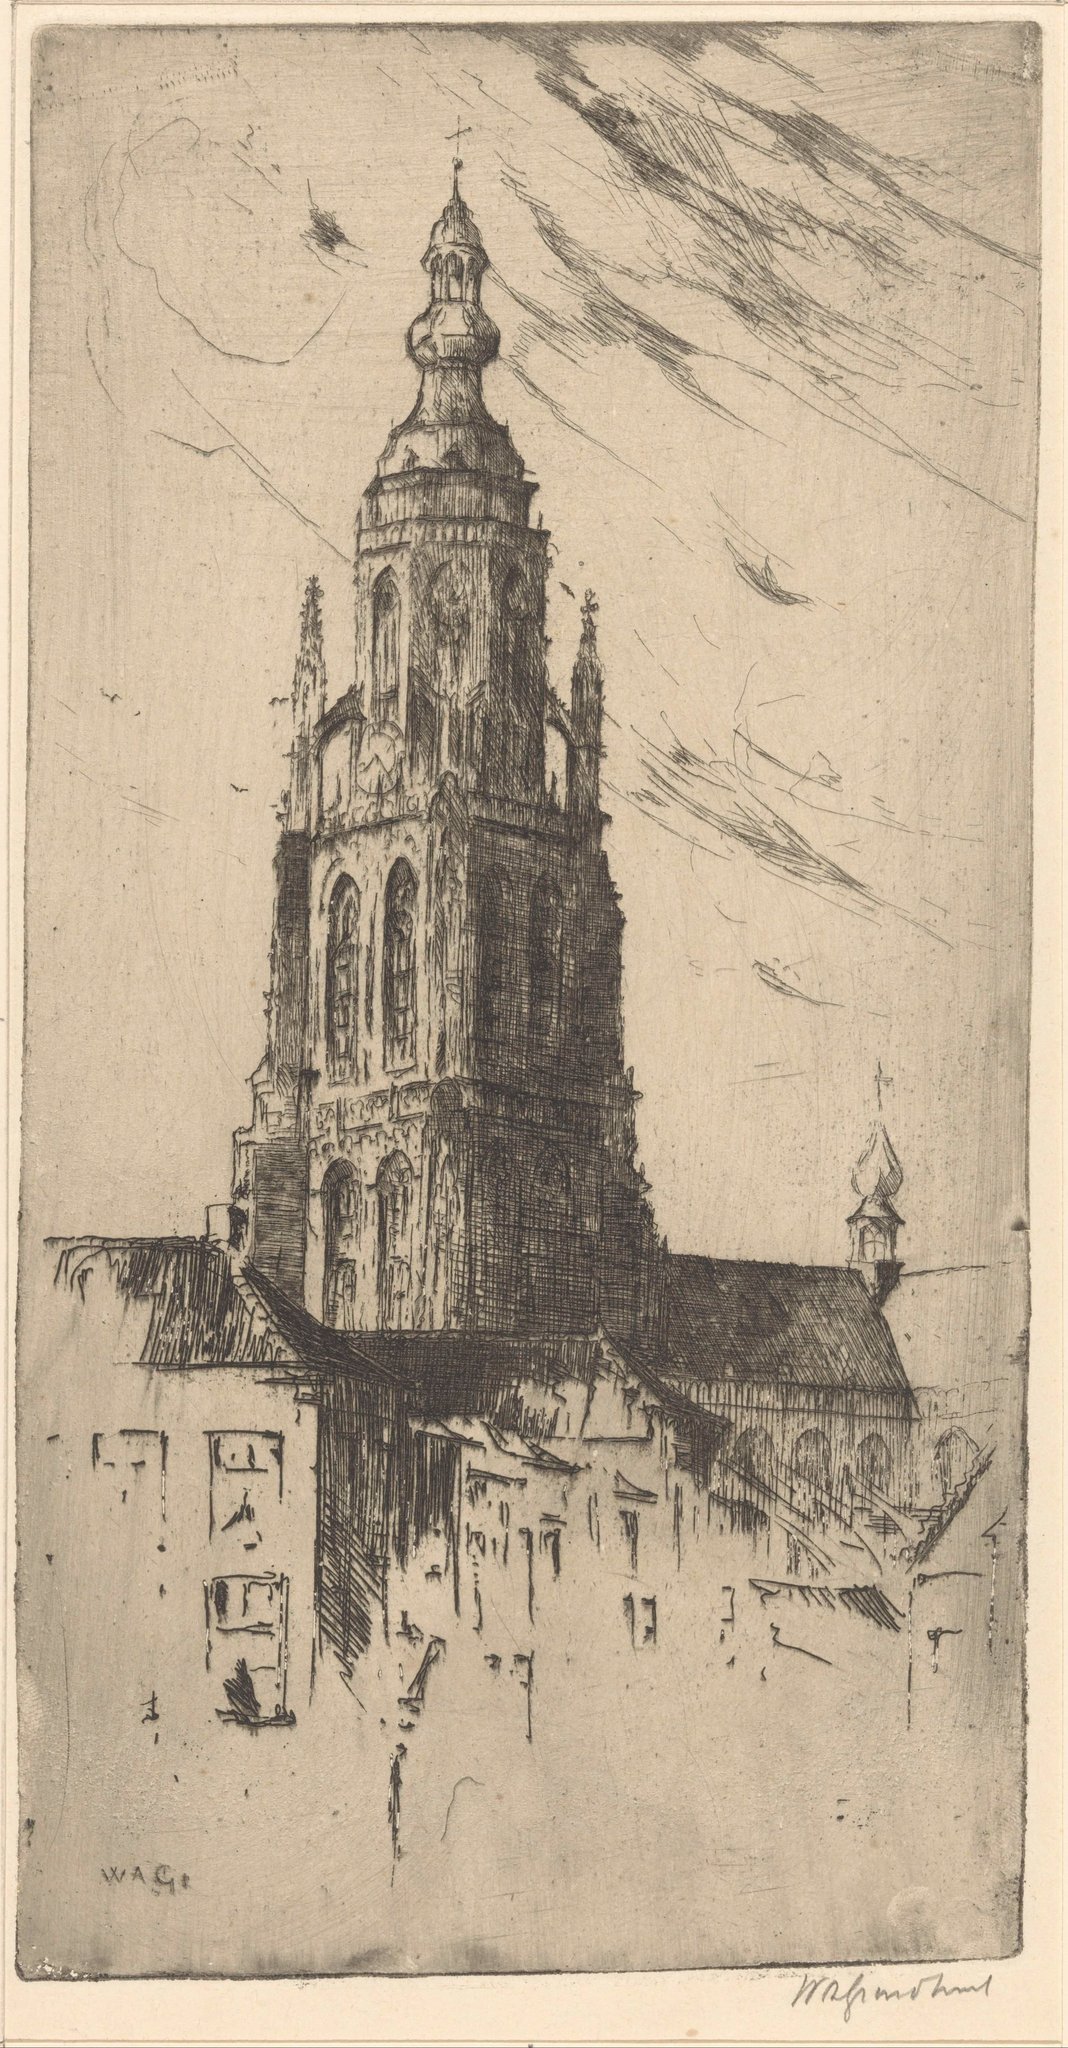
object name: print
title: Toren van de Grote Kerk in Breda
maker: willem adrianus grondhout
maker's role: draughtsman, painter, print maker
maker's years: 1878-1934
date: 1888-1934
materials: paper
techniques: etching, intaglio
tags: parts of church exterior and annexes: tower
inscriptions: collector's mark: Lugt 2228